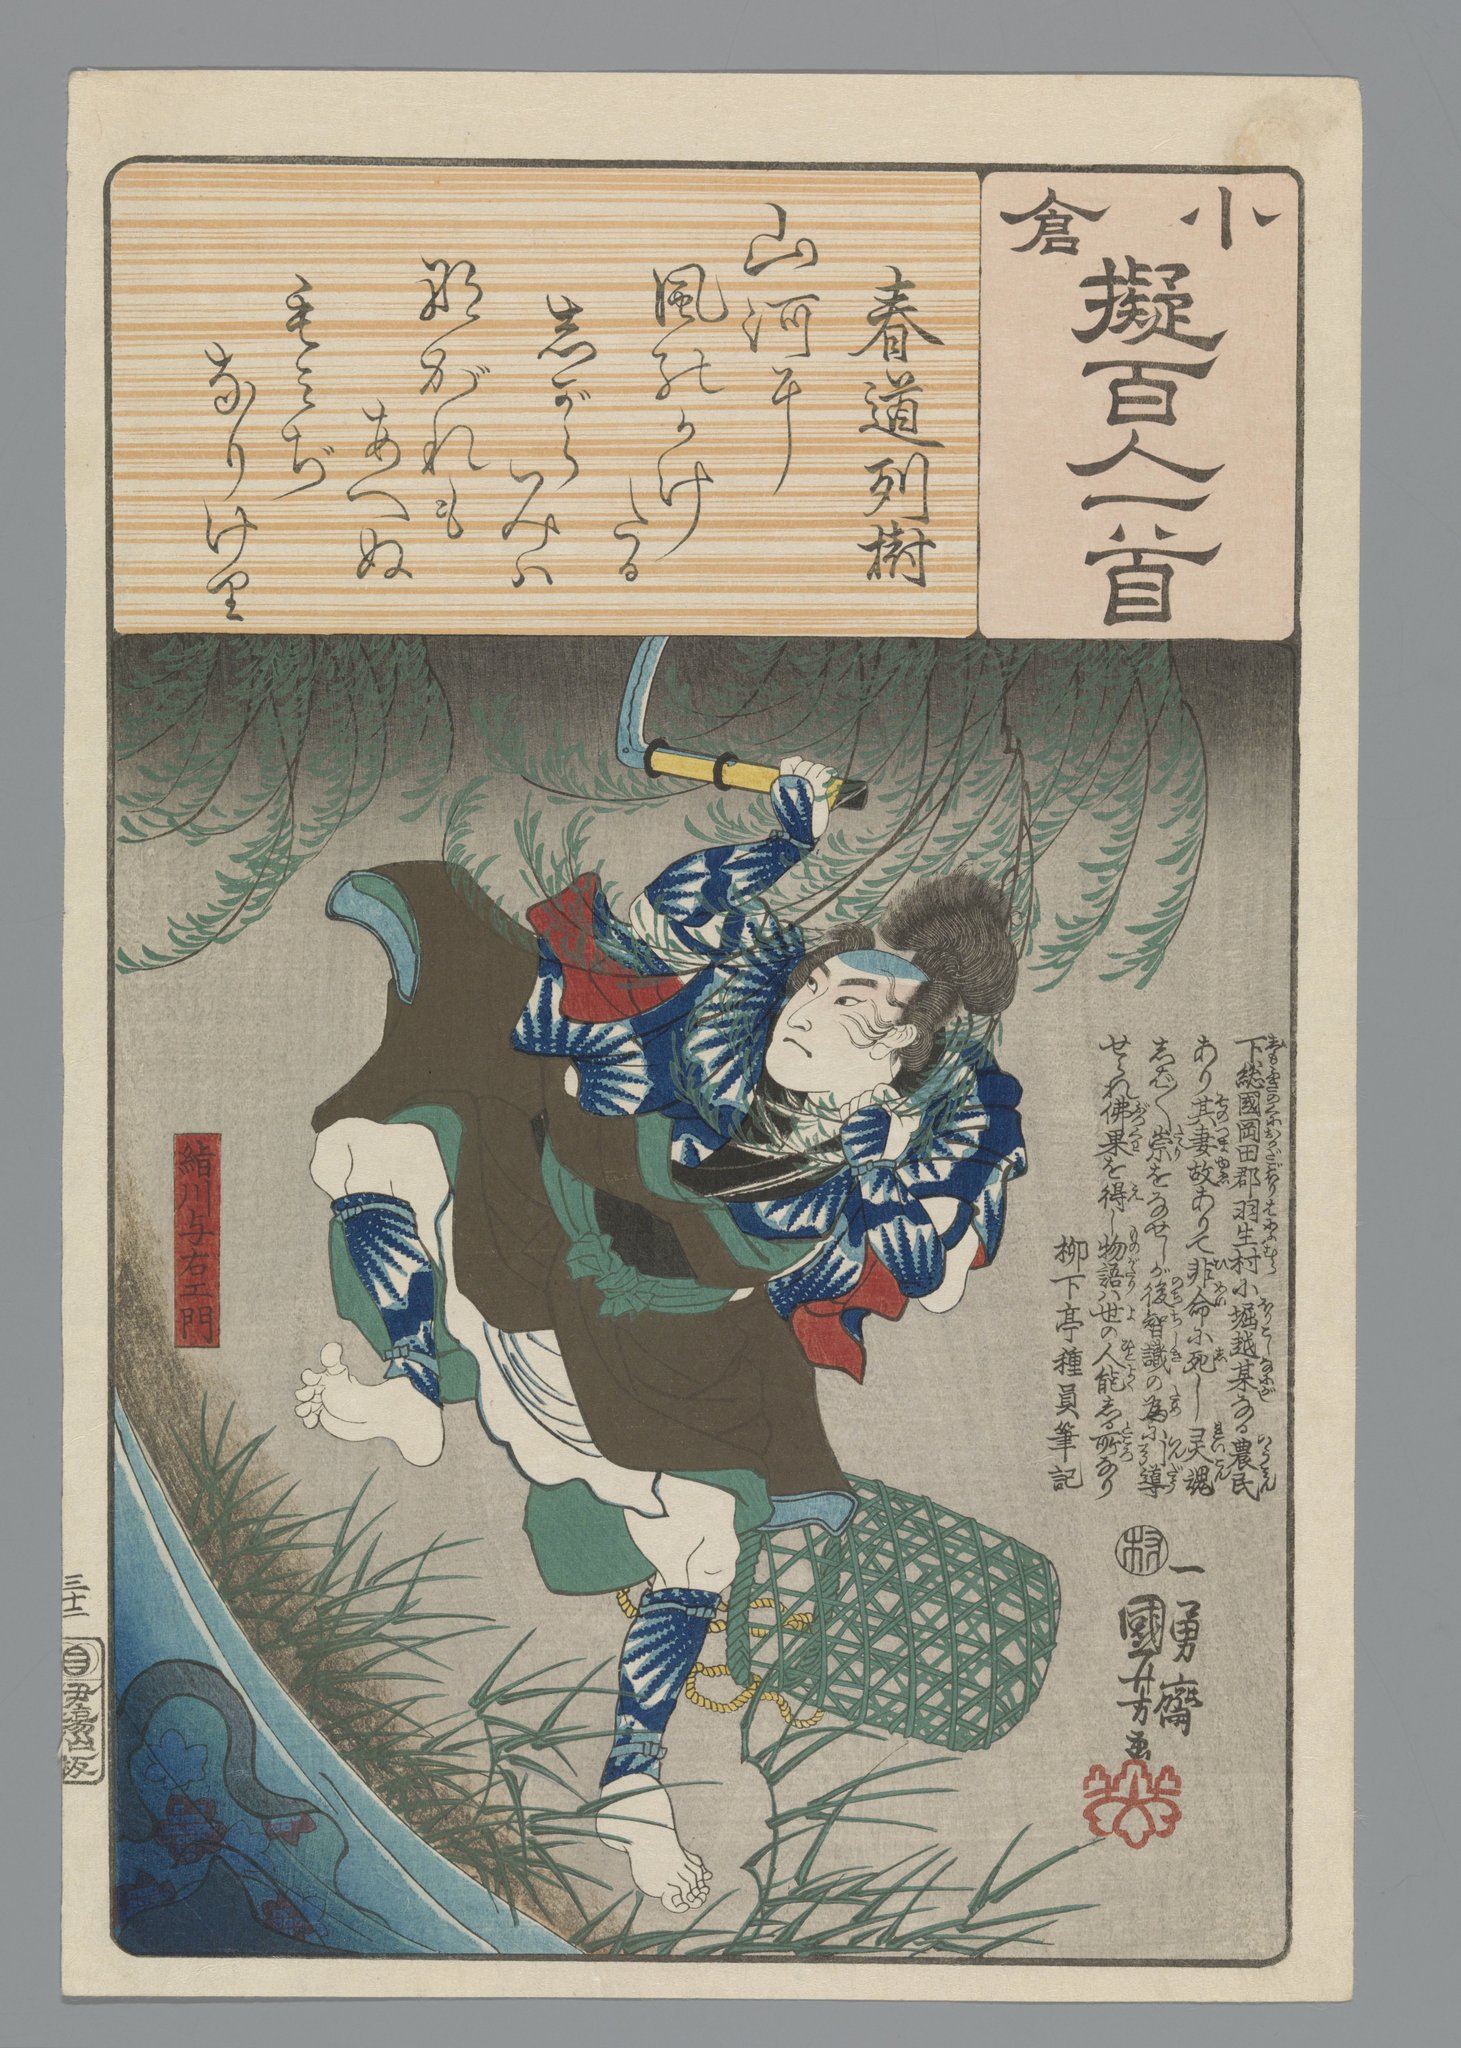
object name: print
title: Ogura Imitation of the One Hundred Poems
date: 1845-1848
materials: paper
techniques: woodcut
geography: japan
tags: wooden container: barrel, cask, bucket, river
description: Kinugawa Yoemon met mand en sikkel nabij een rivier waarin de mouwen zichtbaar zijn van zijn geliefde en door hem vermoorde Kasane. Scene uit een kabukitoneelstuk. Gedicht door Harumichi no Tsuraki.